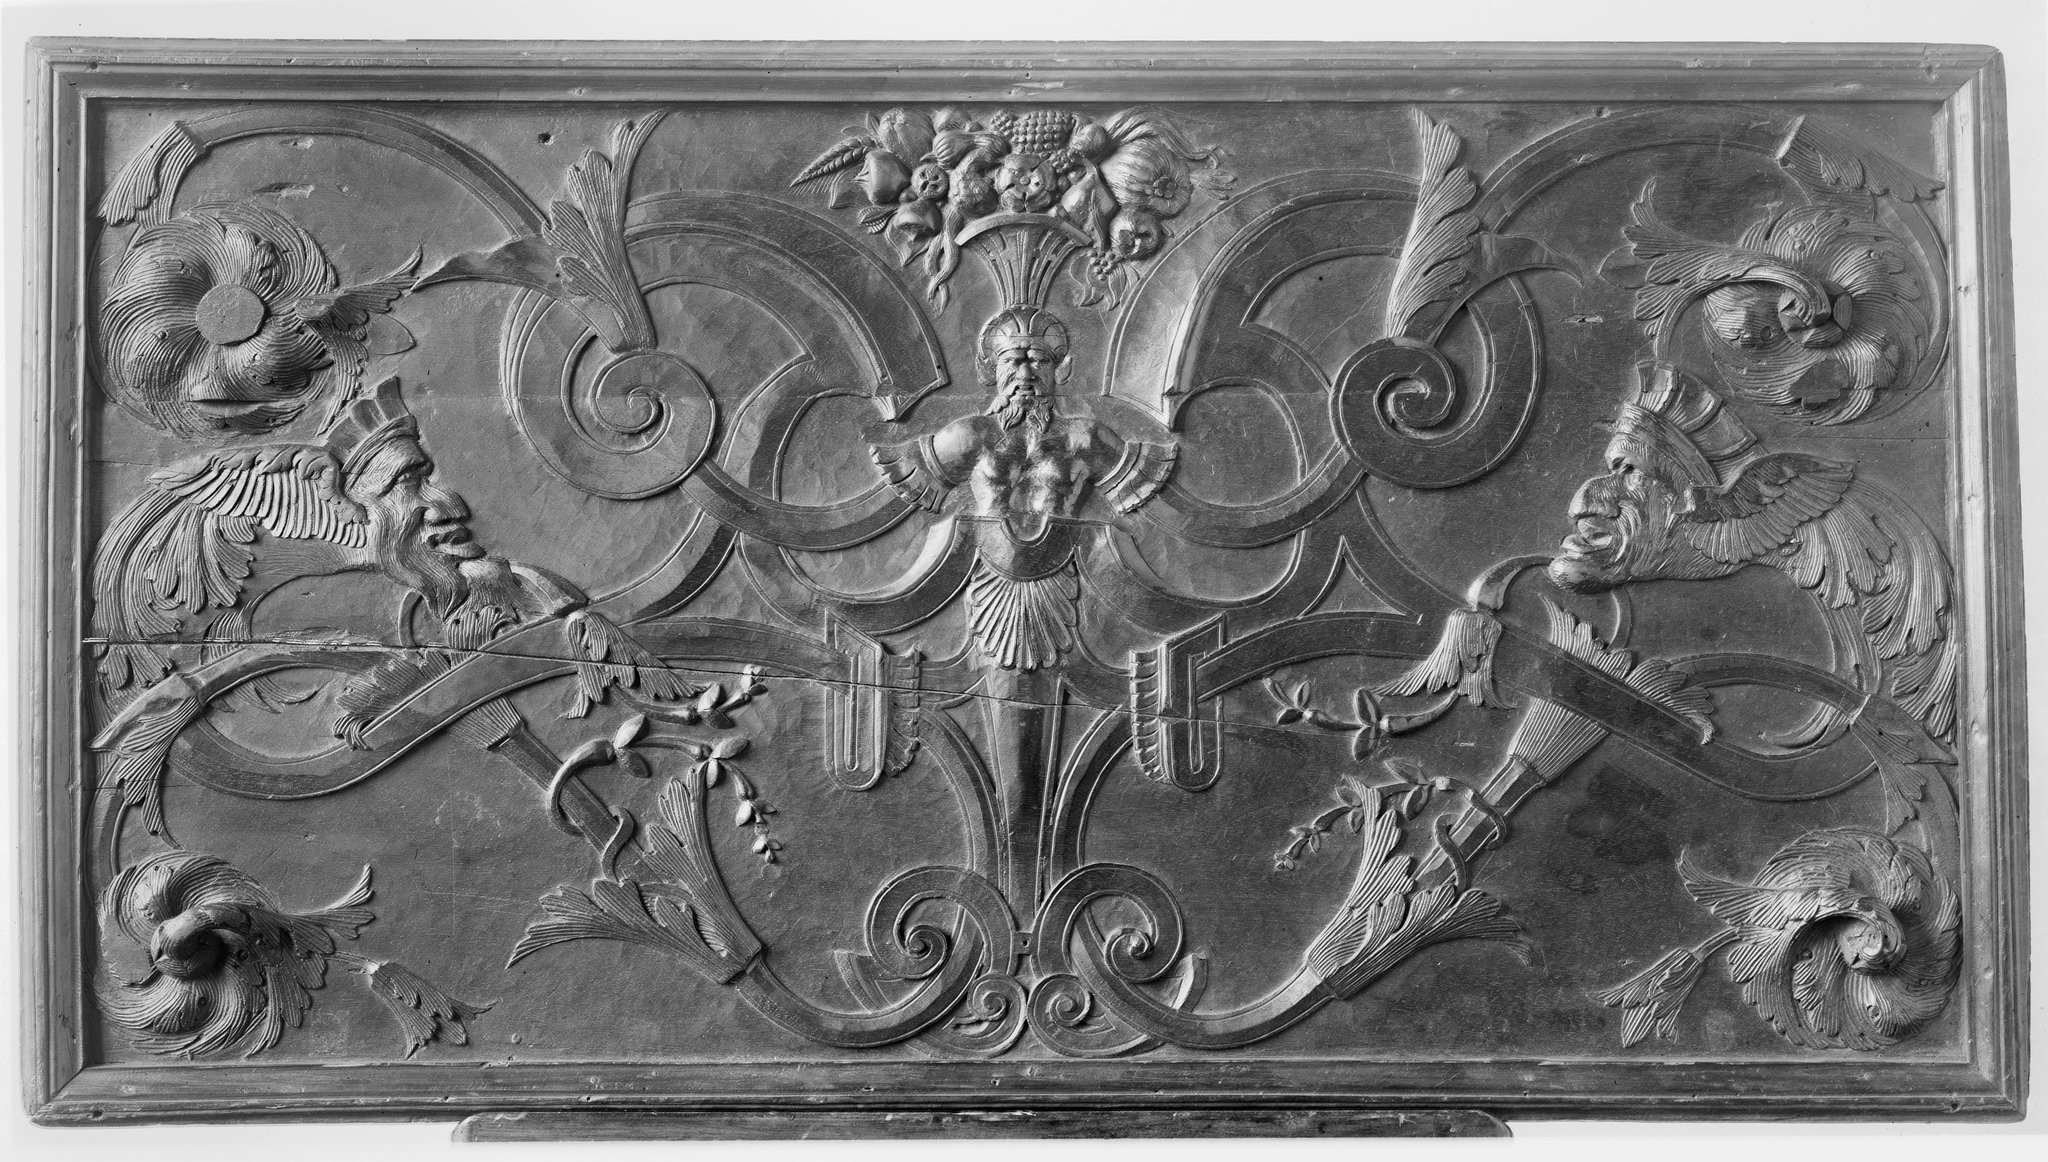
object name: panel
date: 1567-1600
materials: wood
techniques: carving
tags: faces,men